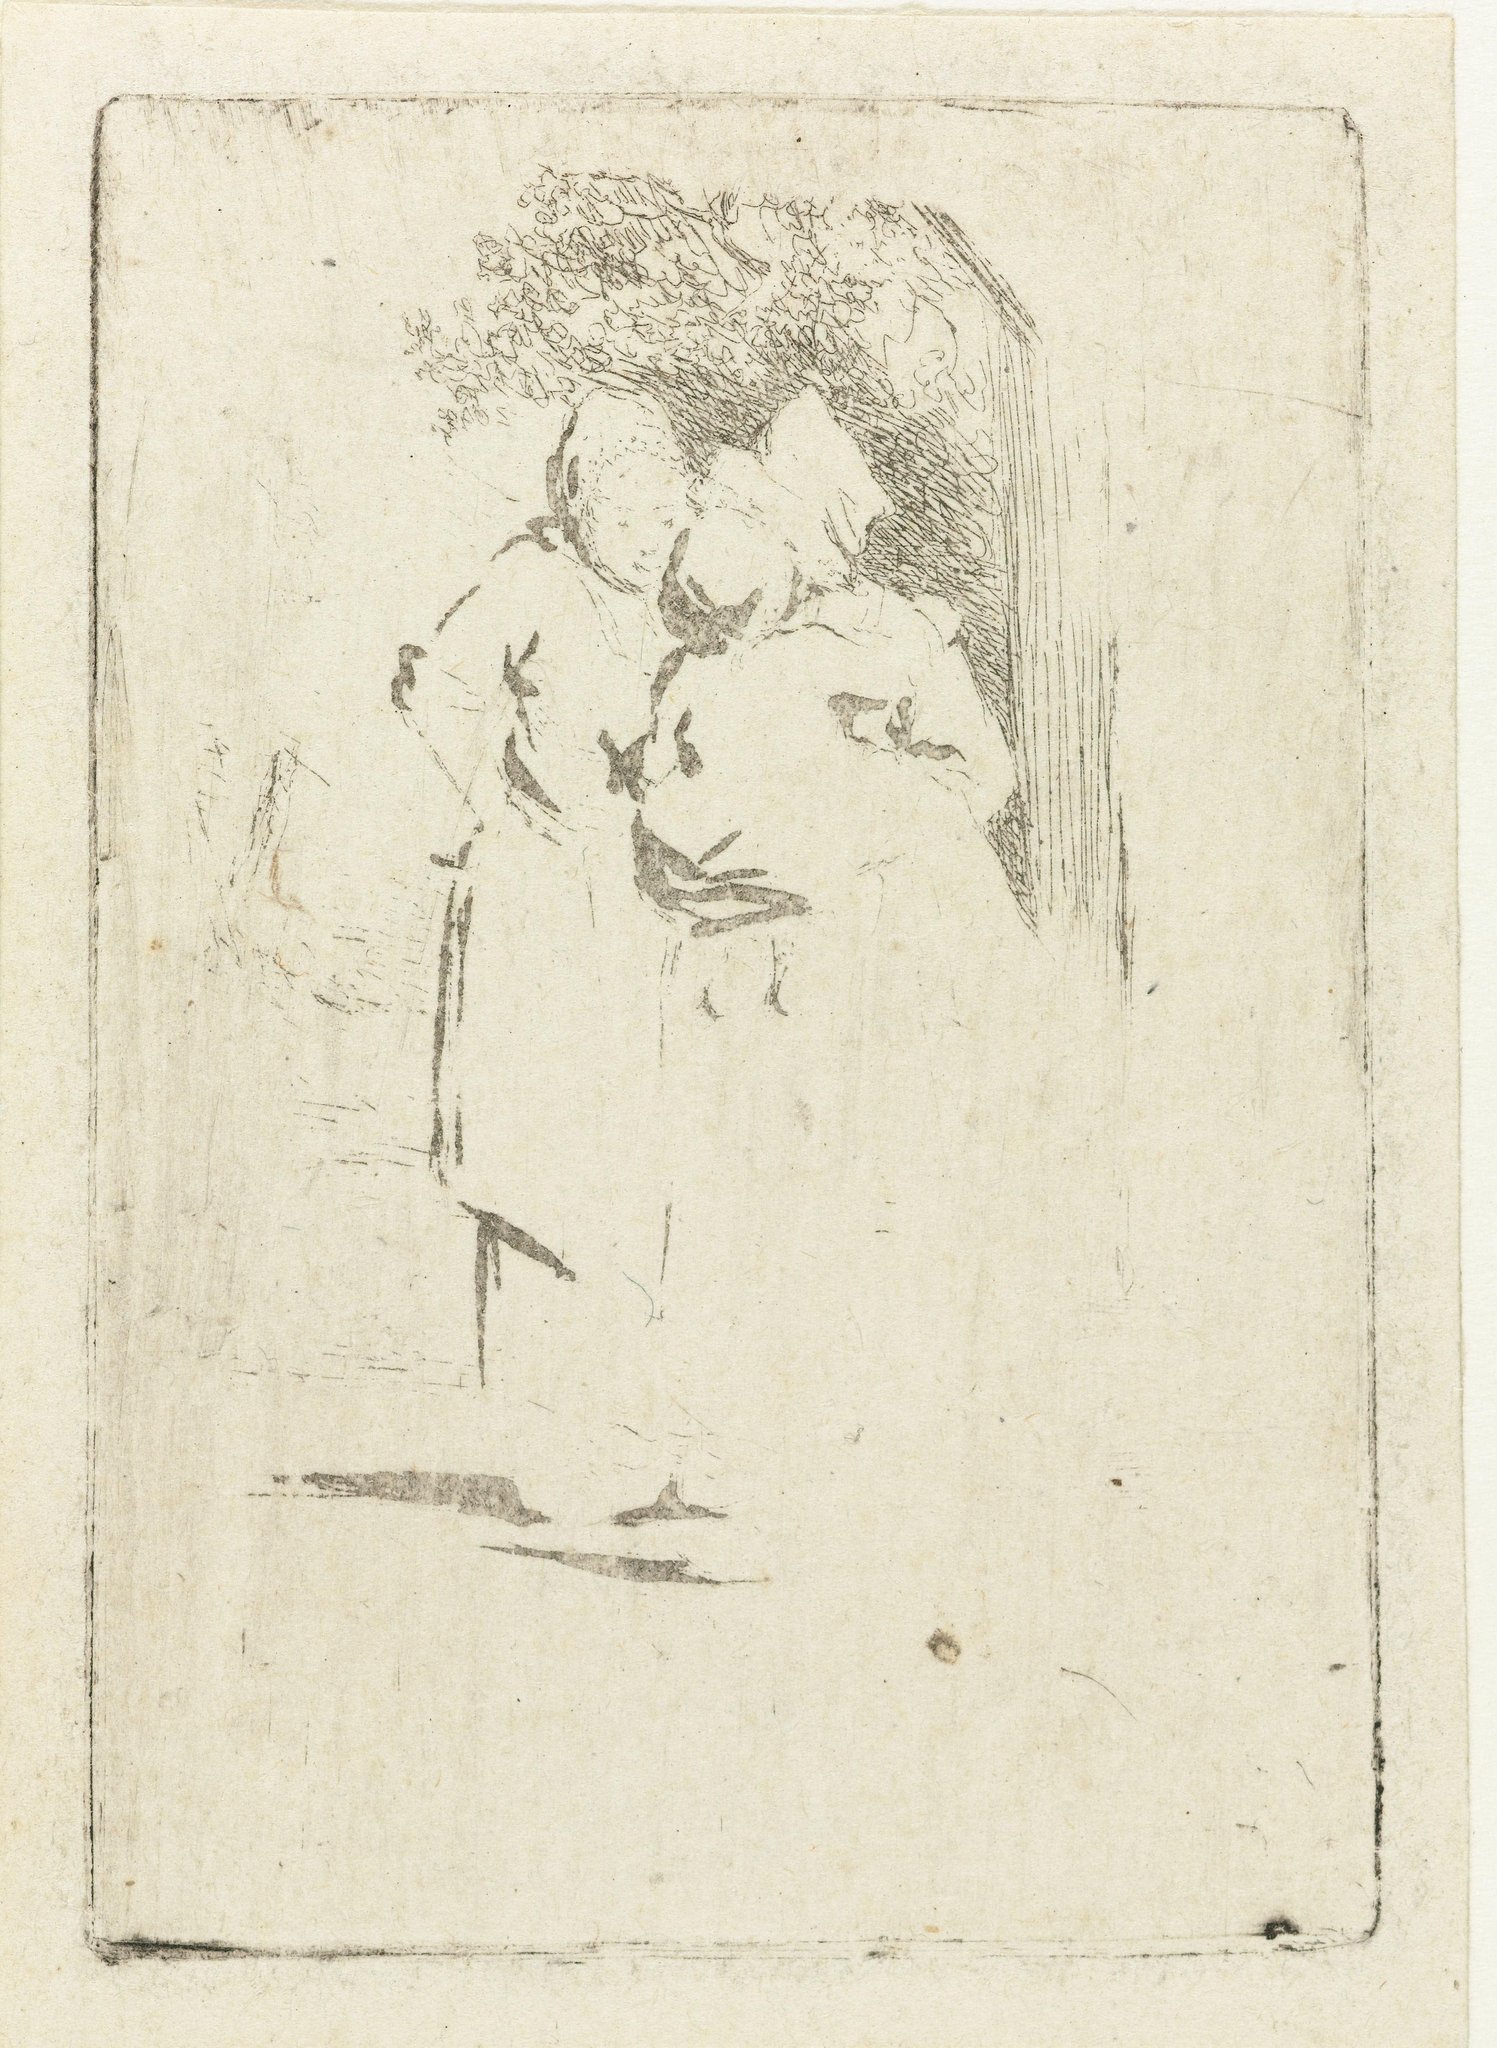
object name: print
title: Twee staande boerinnen, eentje met een kind op haar arm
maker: marie lambertine coclers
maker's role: conservator, draughtsman, print maker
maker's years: 1761-1815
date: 1776-1815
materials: paper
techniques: aquatint, drypoint, etching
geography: amsterdam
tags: mother and baby or young child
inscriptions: collector's mark: Lugt 2228